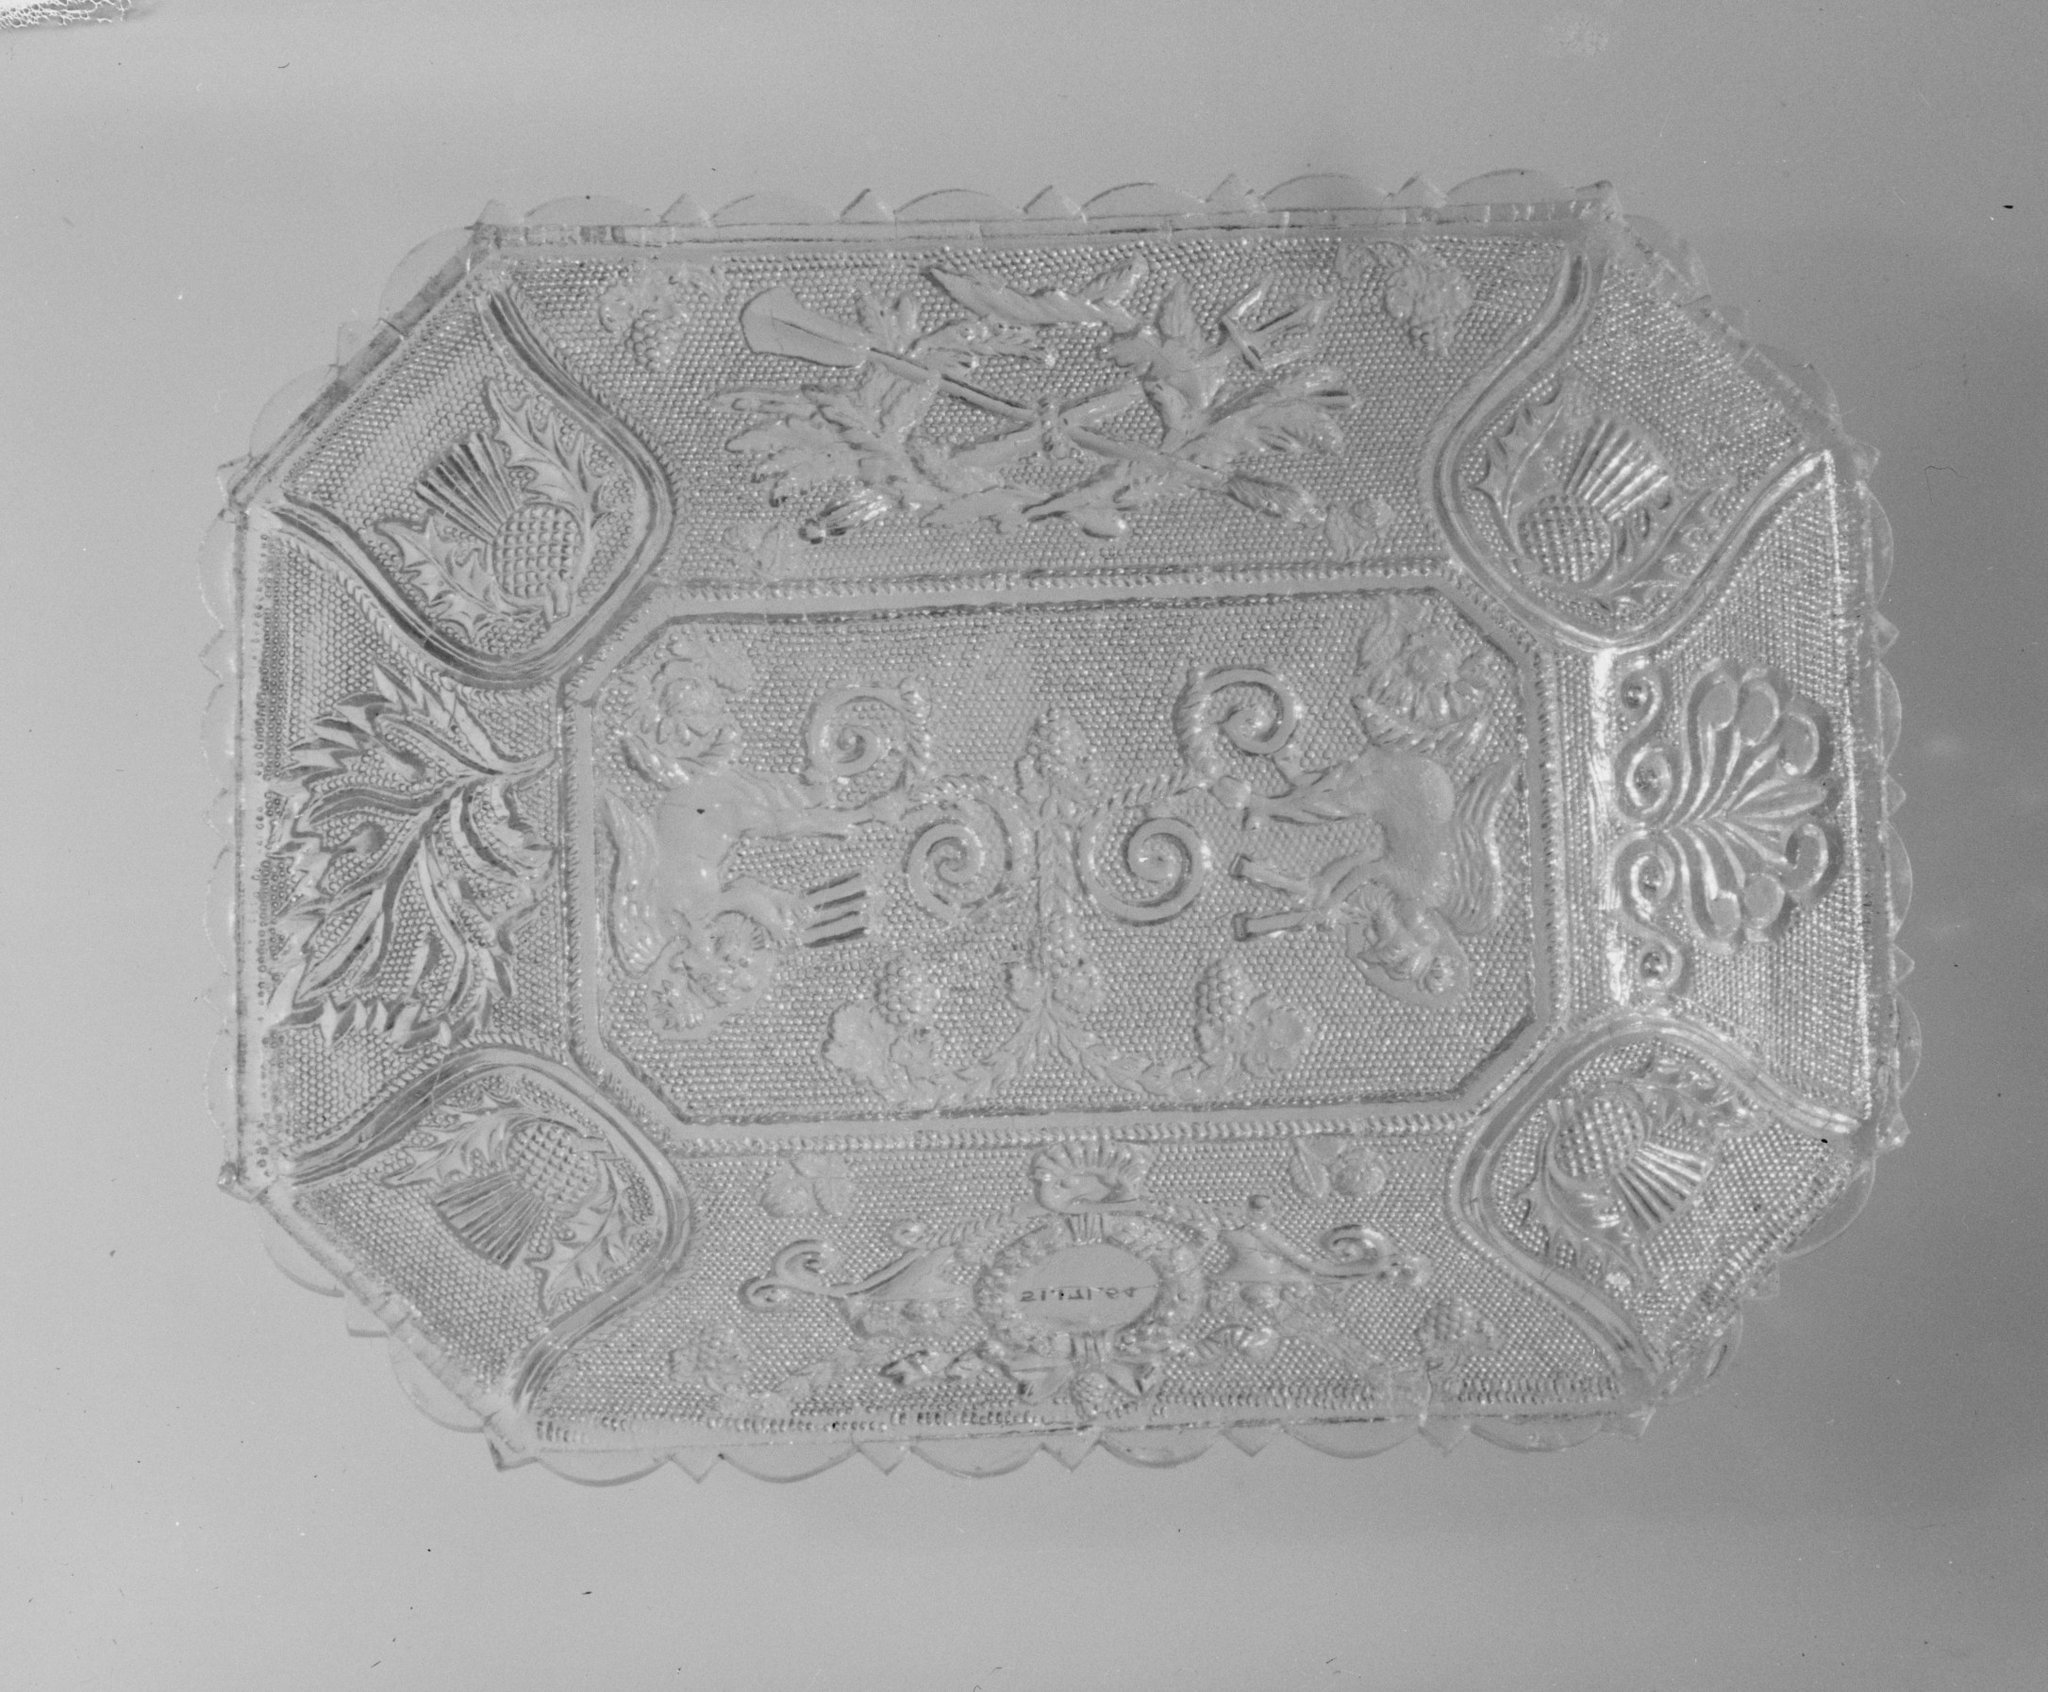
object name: dish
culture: american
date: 1830-1845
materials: glass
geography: united states